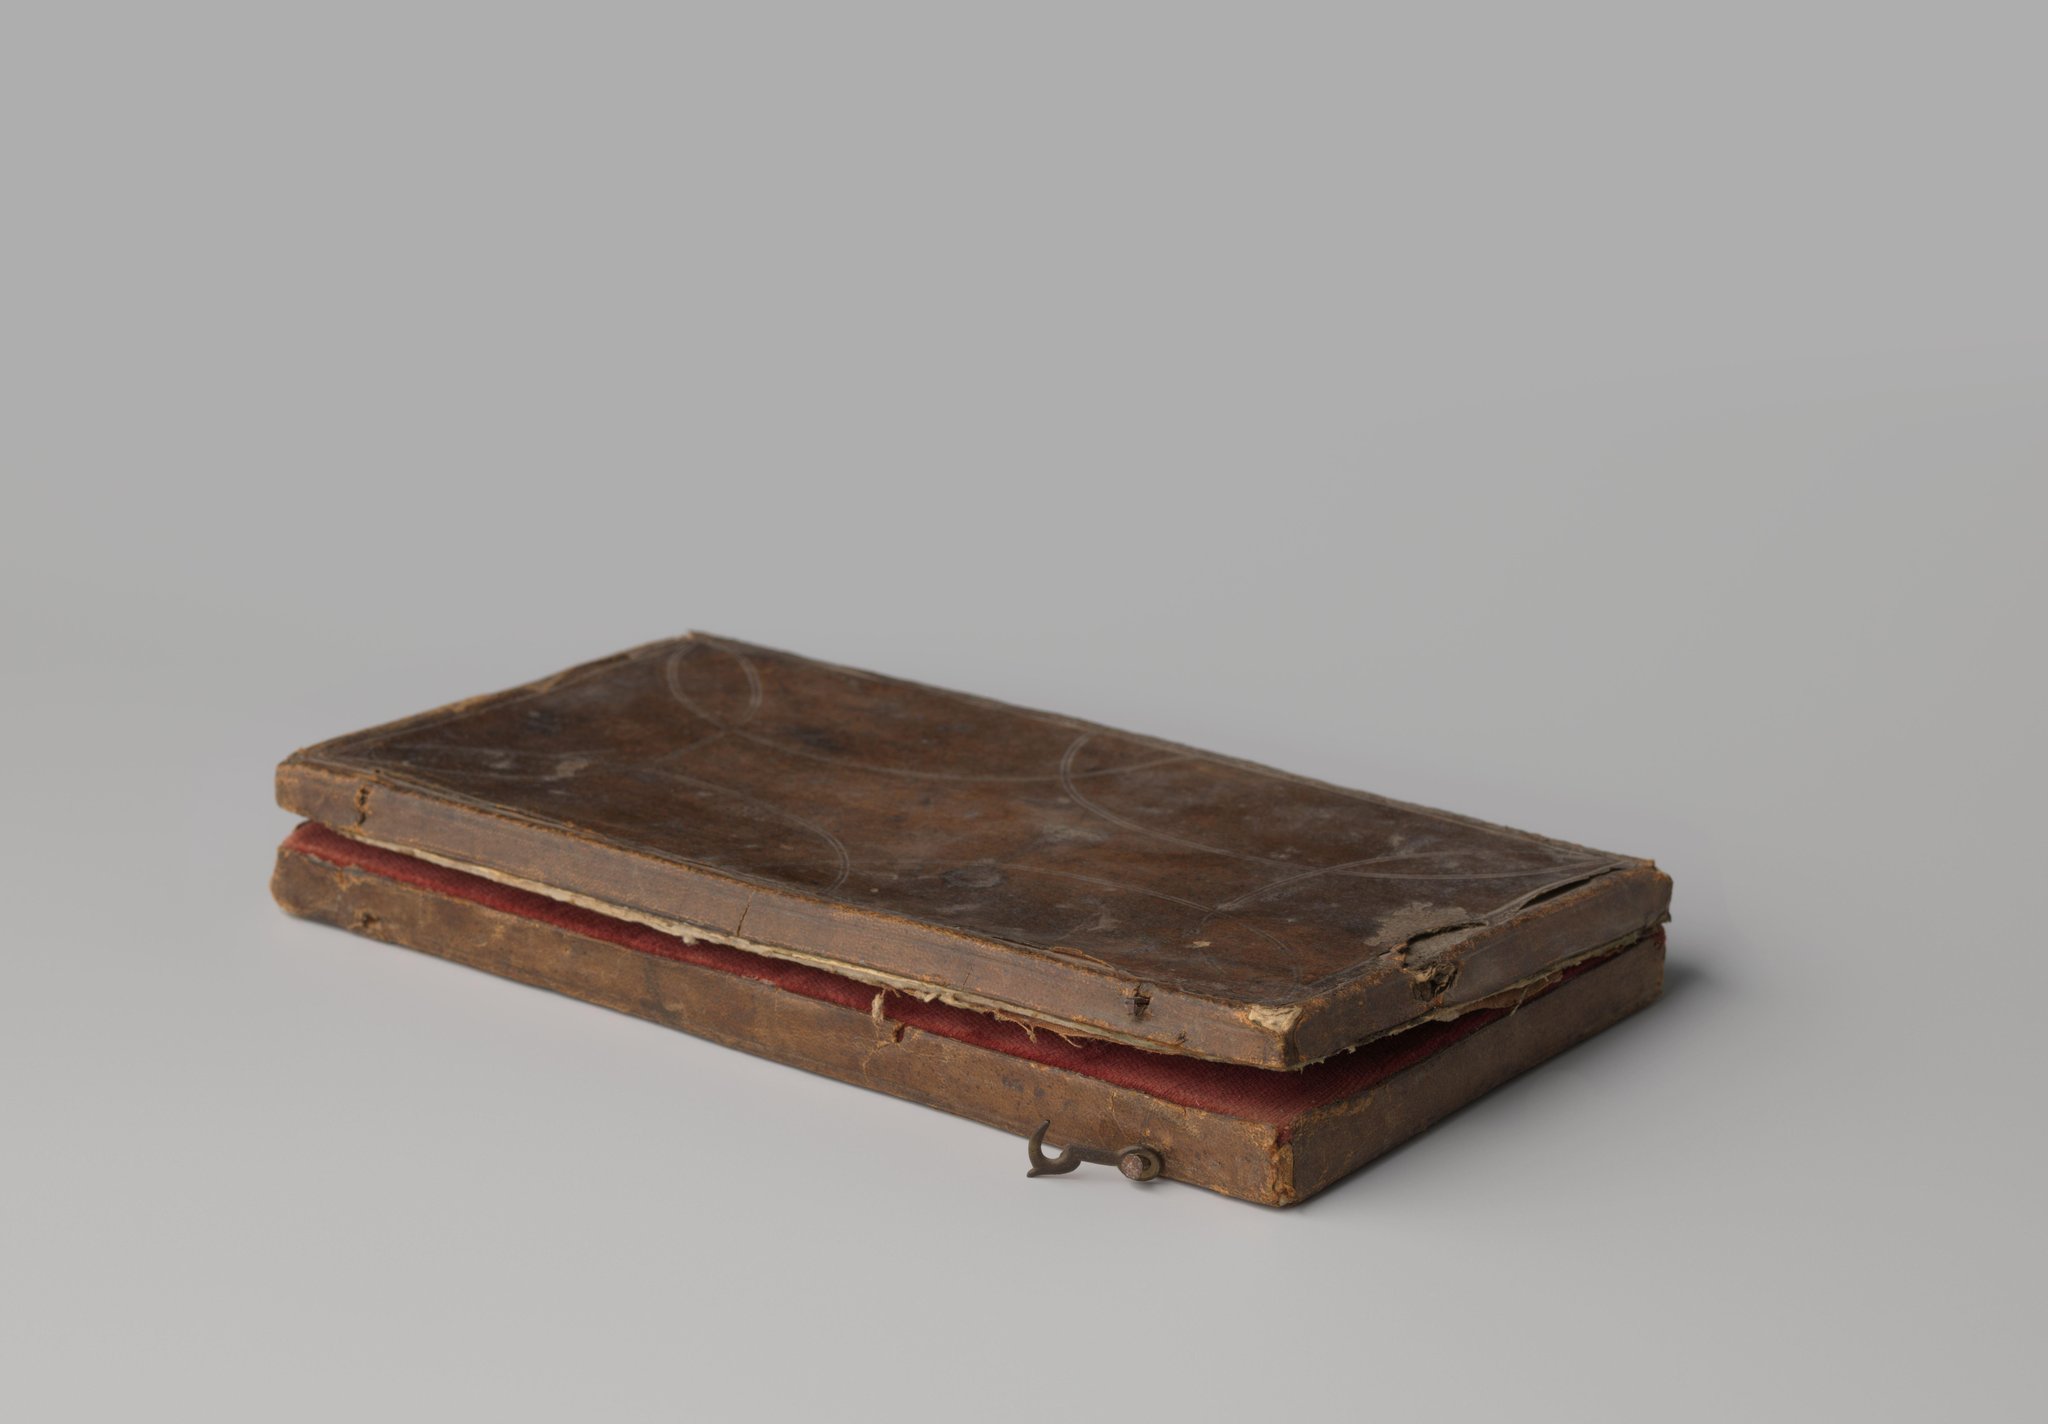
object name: case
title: Foedraal van de sleutel van de stad Bremen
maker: Anonymous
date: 1875-1925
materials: cardboard, leather, silk, velvet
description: Symbolische pijpsleutel van de stad Bremen, waarvan de greep gevormd wordt door een naar beneden gewende C-voluut, waarin zich twee staande leeuwen met afgewende koppen bevinden, het gehoornde stadswapen tussen zich houdend. Greep en baard van tin, schacht van koper. Sleutel in bijbehorend, met leer bekleed, kistje.